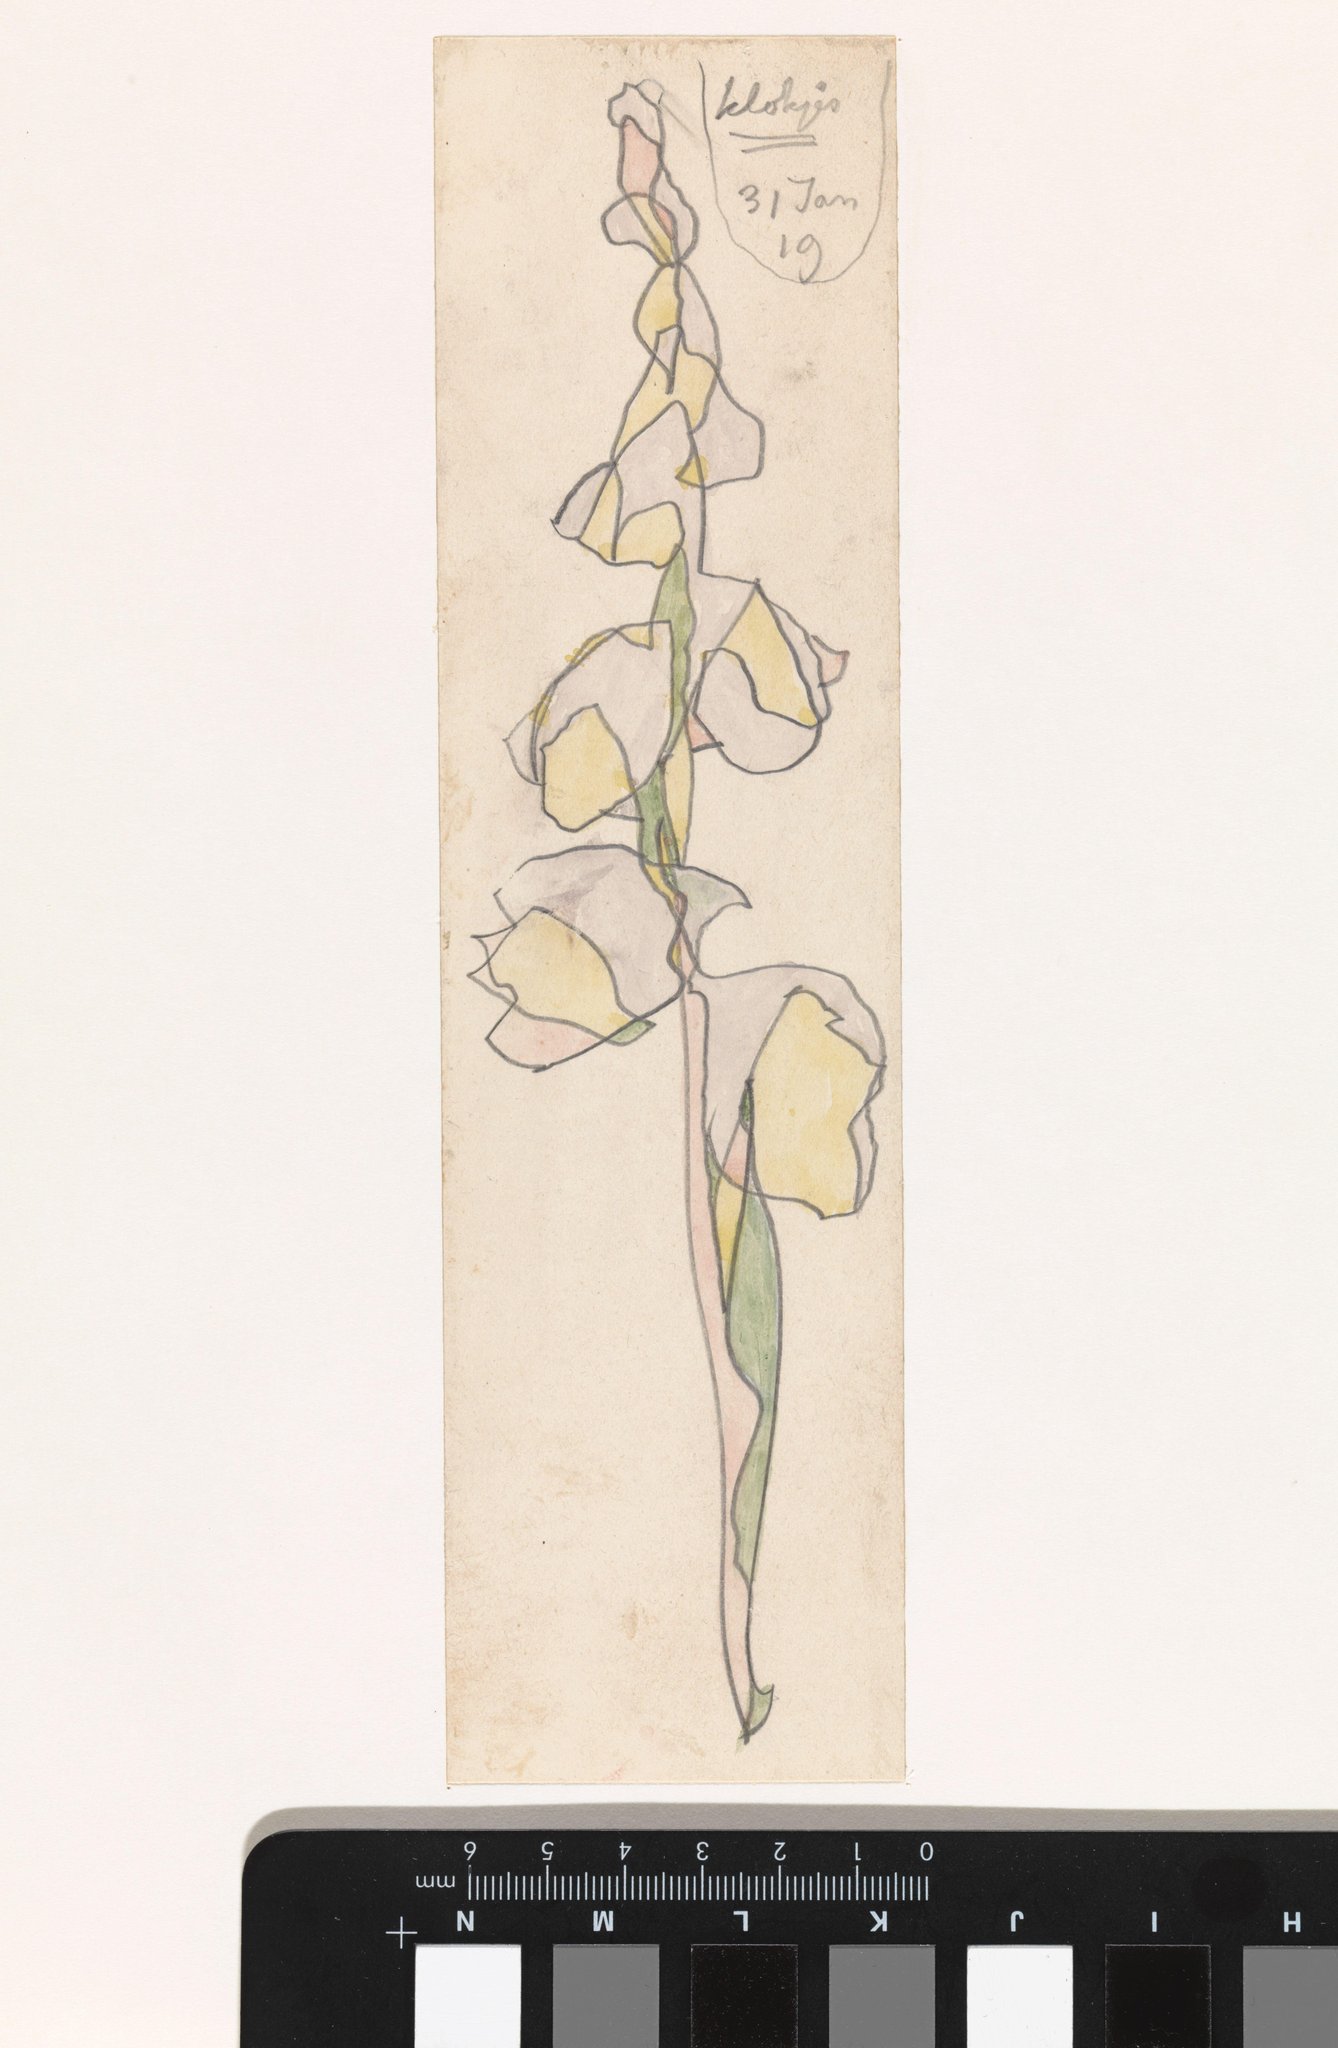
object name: drawing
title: Klokjes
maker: theo colenbrander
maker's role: draughtsman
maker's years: 1841-1930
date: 1919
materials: paper, pencil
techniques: brush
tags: flowers: snowdrop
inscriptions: date: ‘31 Jan 19’